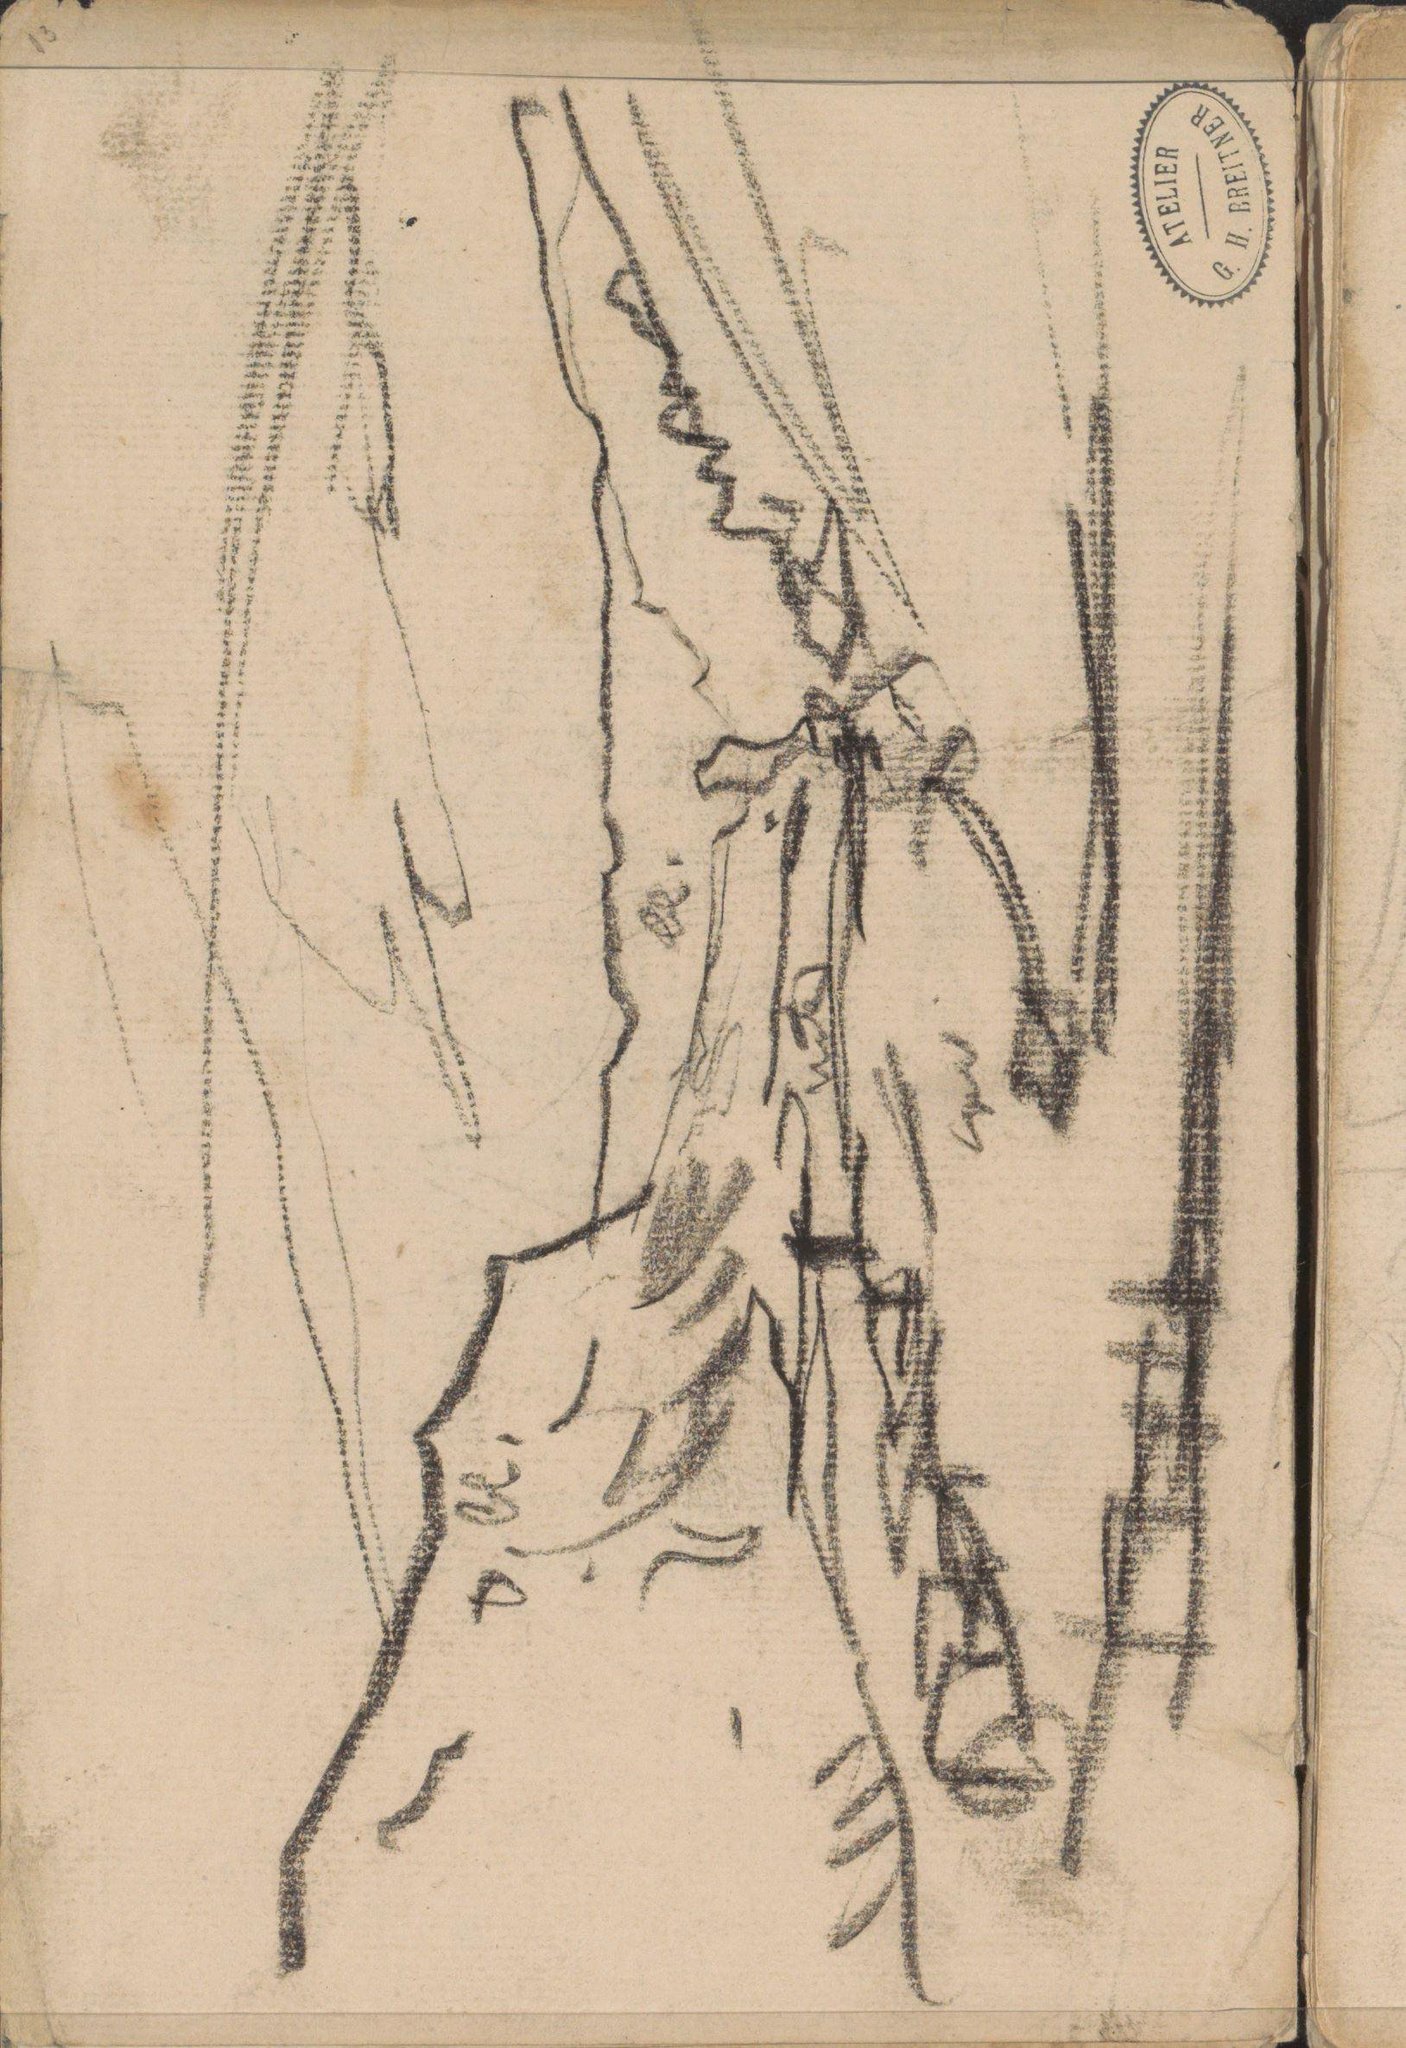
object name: sketchbook leaf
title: Landschap, mogelijk een duinlandschap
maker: george hendrik breitner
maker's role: draughtsman, painter, print maker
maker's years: 1857-1923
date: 1886-1923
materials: chalk, paper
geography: amsterdam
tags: dune coast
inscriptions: workshop stamp: Lugt 291d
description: Pagina 13 uit een schetsboek met 19 bladen en 9 losse tekeningen.